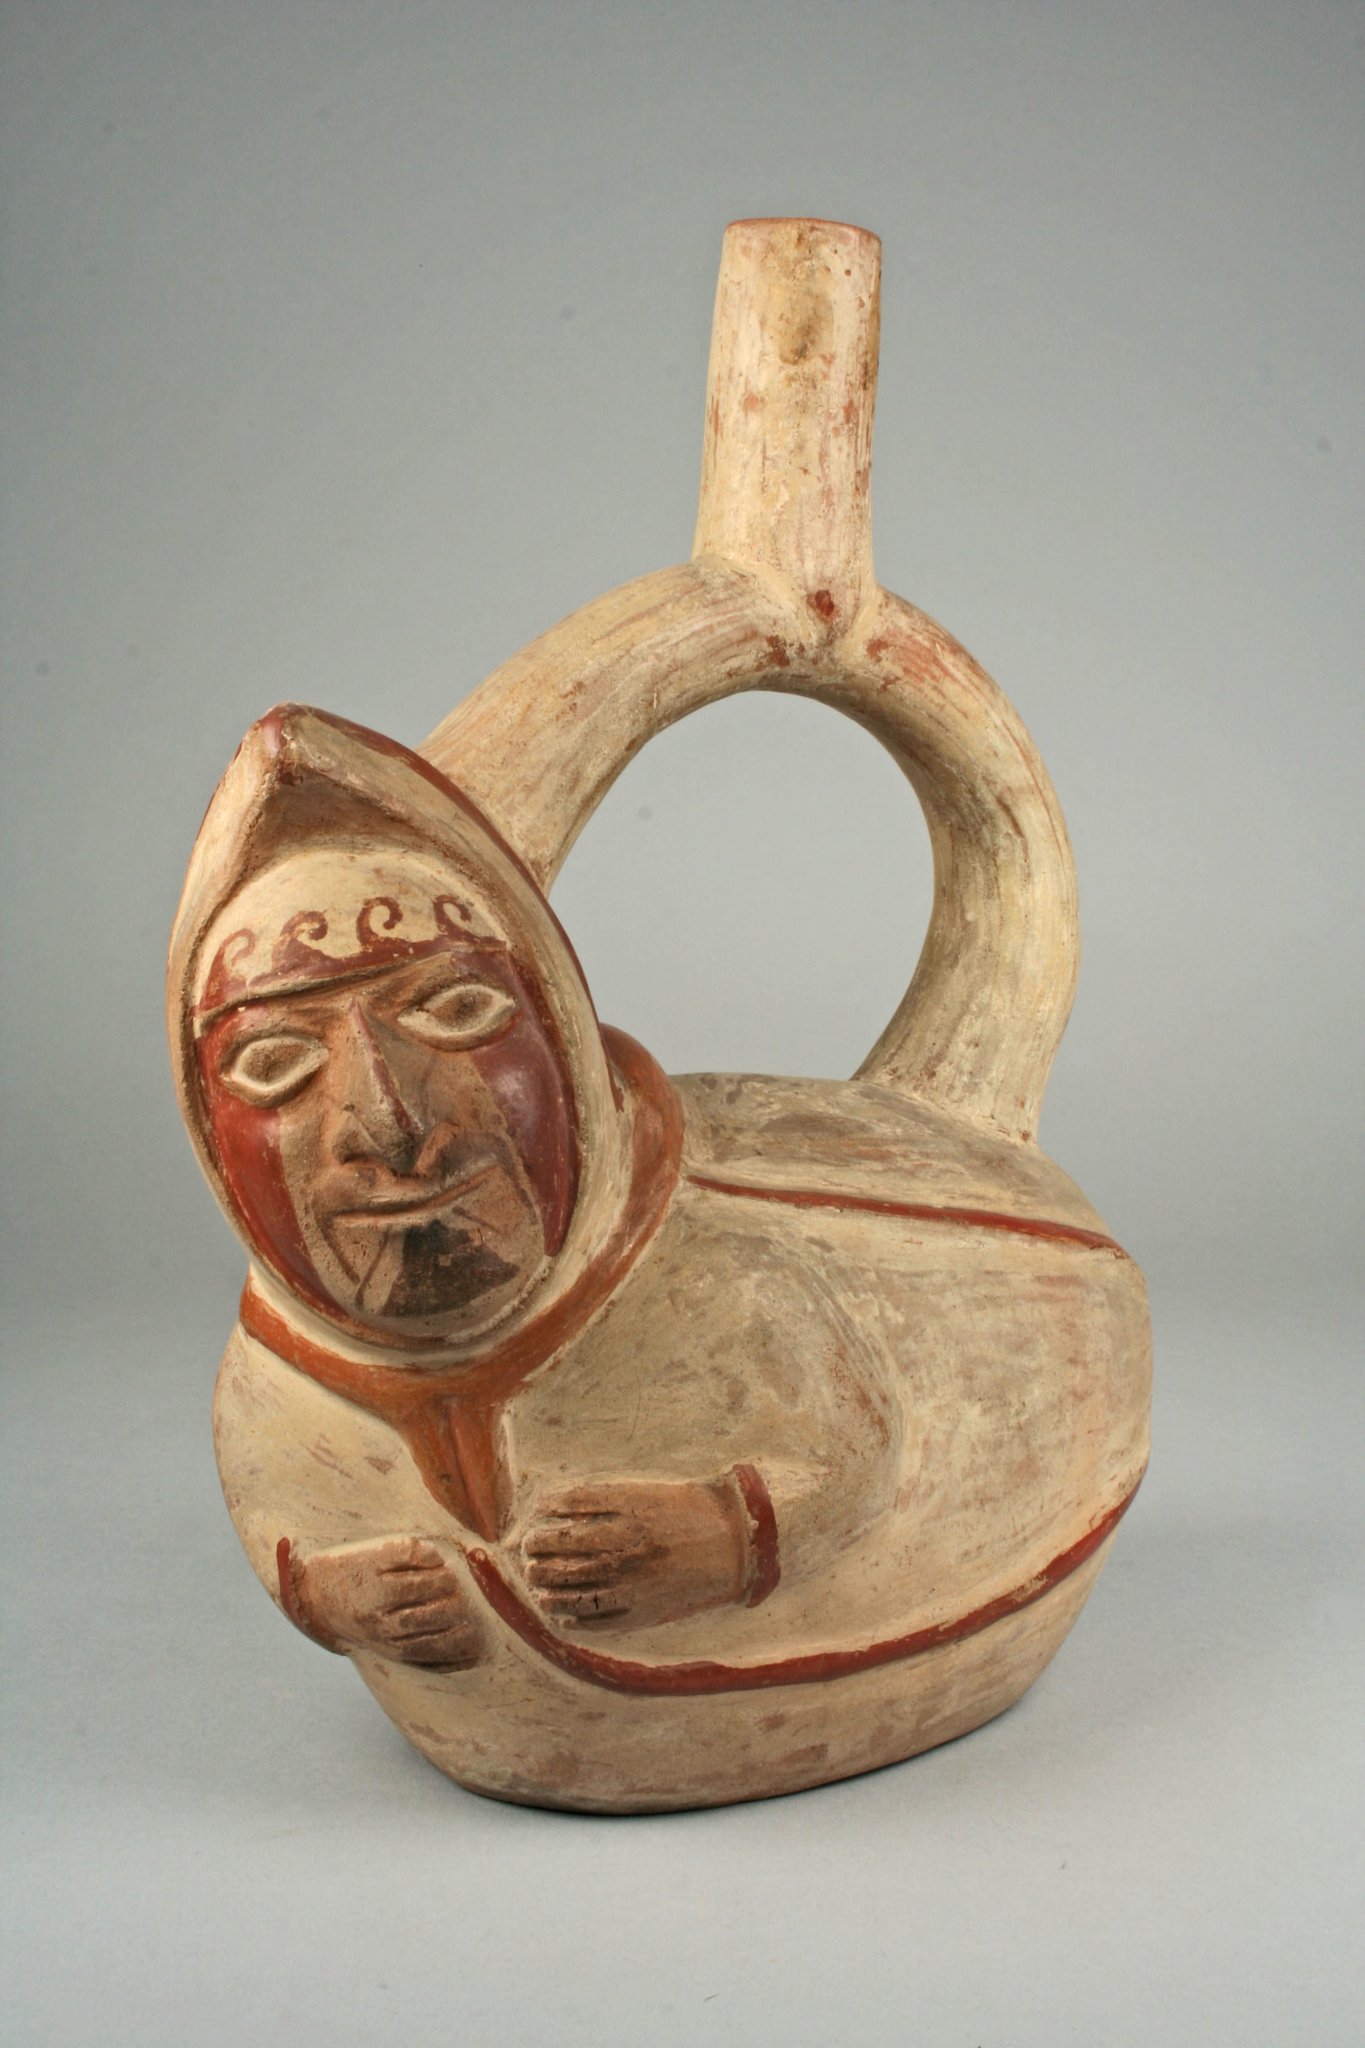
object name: bottle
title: Stirrup Spout Bottle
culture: moche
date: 100 BCE-700 CE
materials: ceramic, pigment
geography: peru